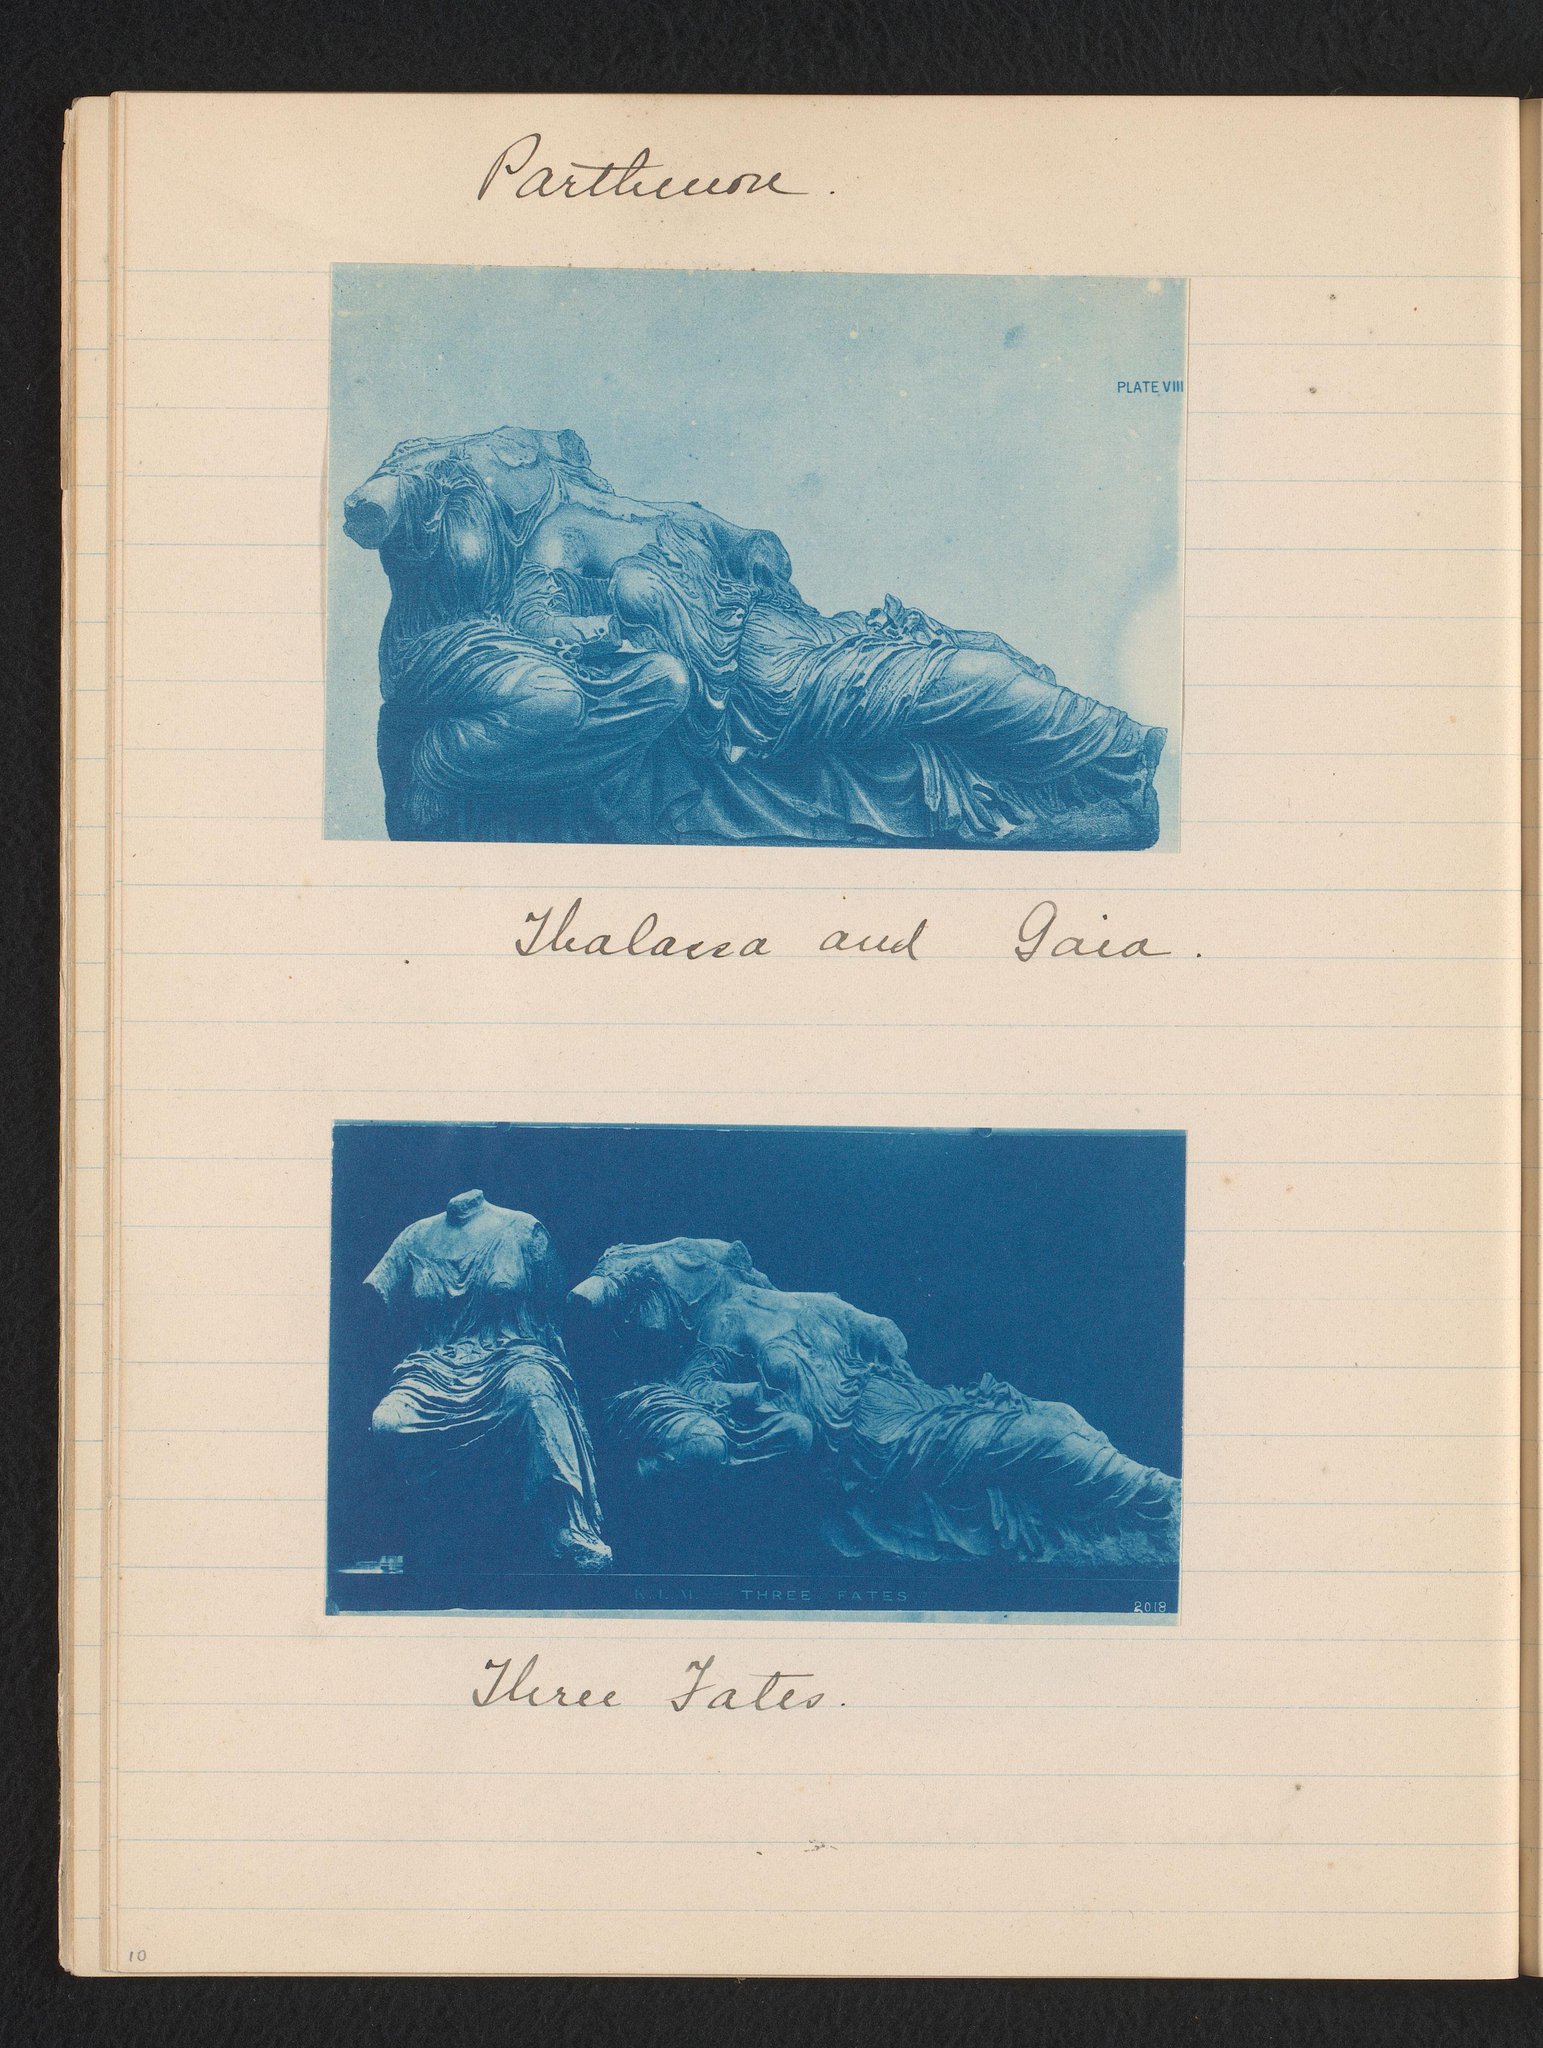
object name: photograph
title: Parthenon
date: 1901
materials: paper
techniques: cyanotype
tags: piece of sculpture, reproduction of a piece of sculpture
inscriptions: inscription: ‘Thalassa and Gaia/ Three Fates’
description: Deze foto's maken deel uit van een album.